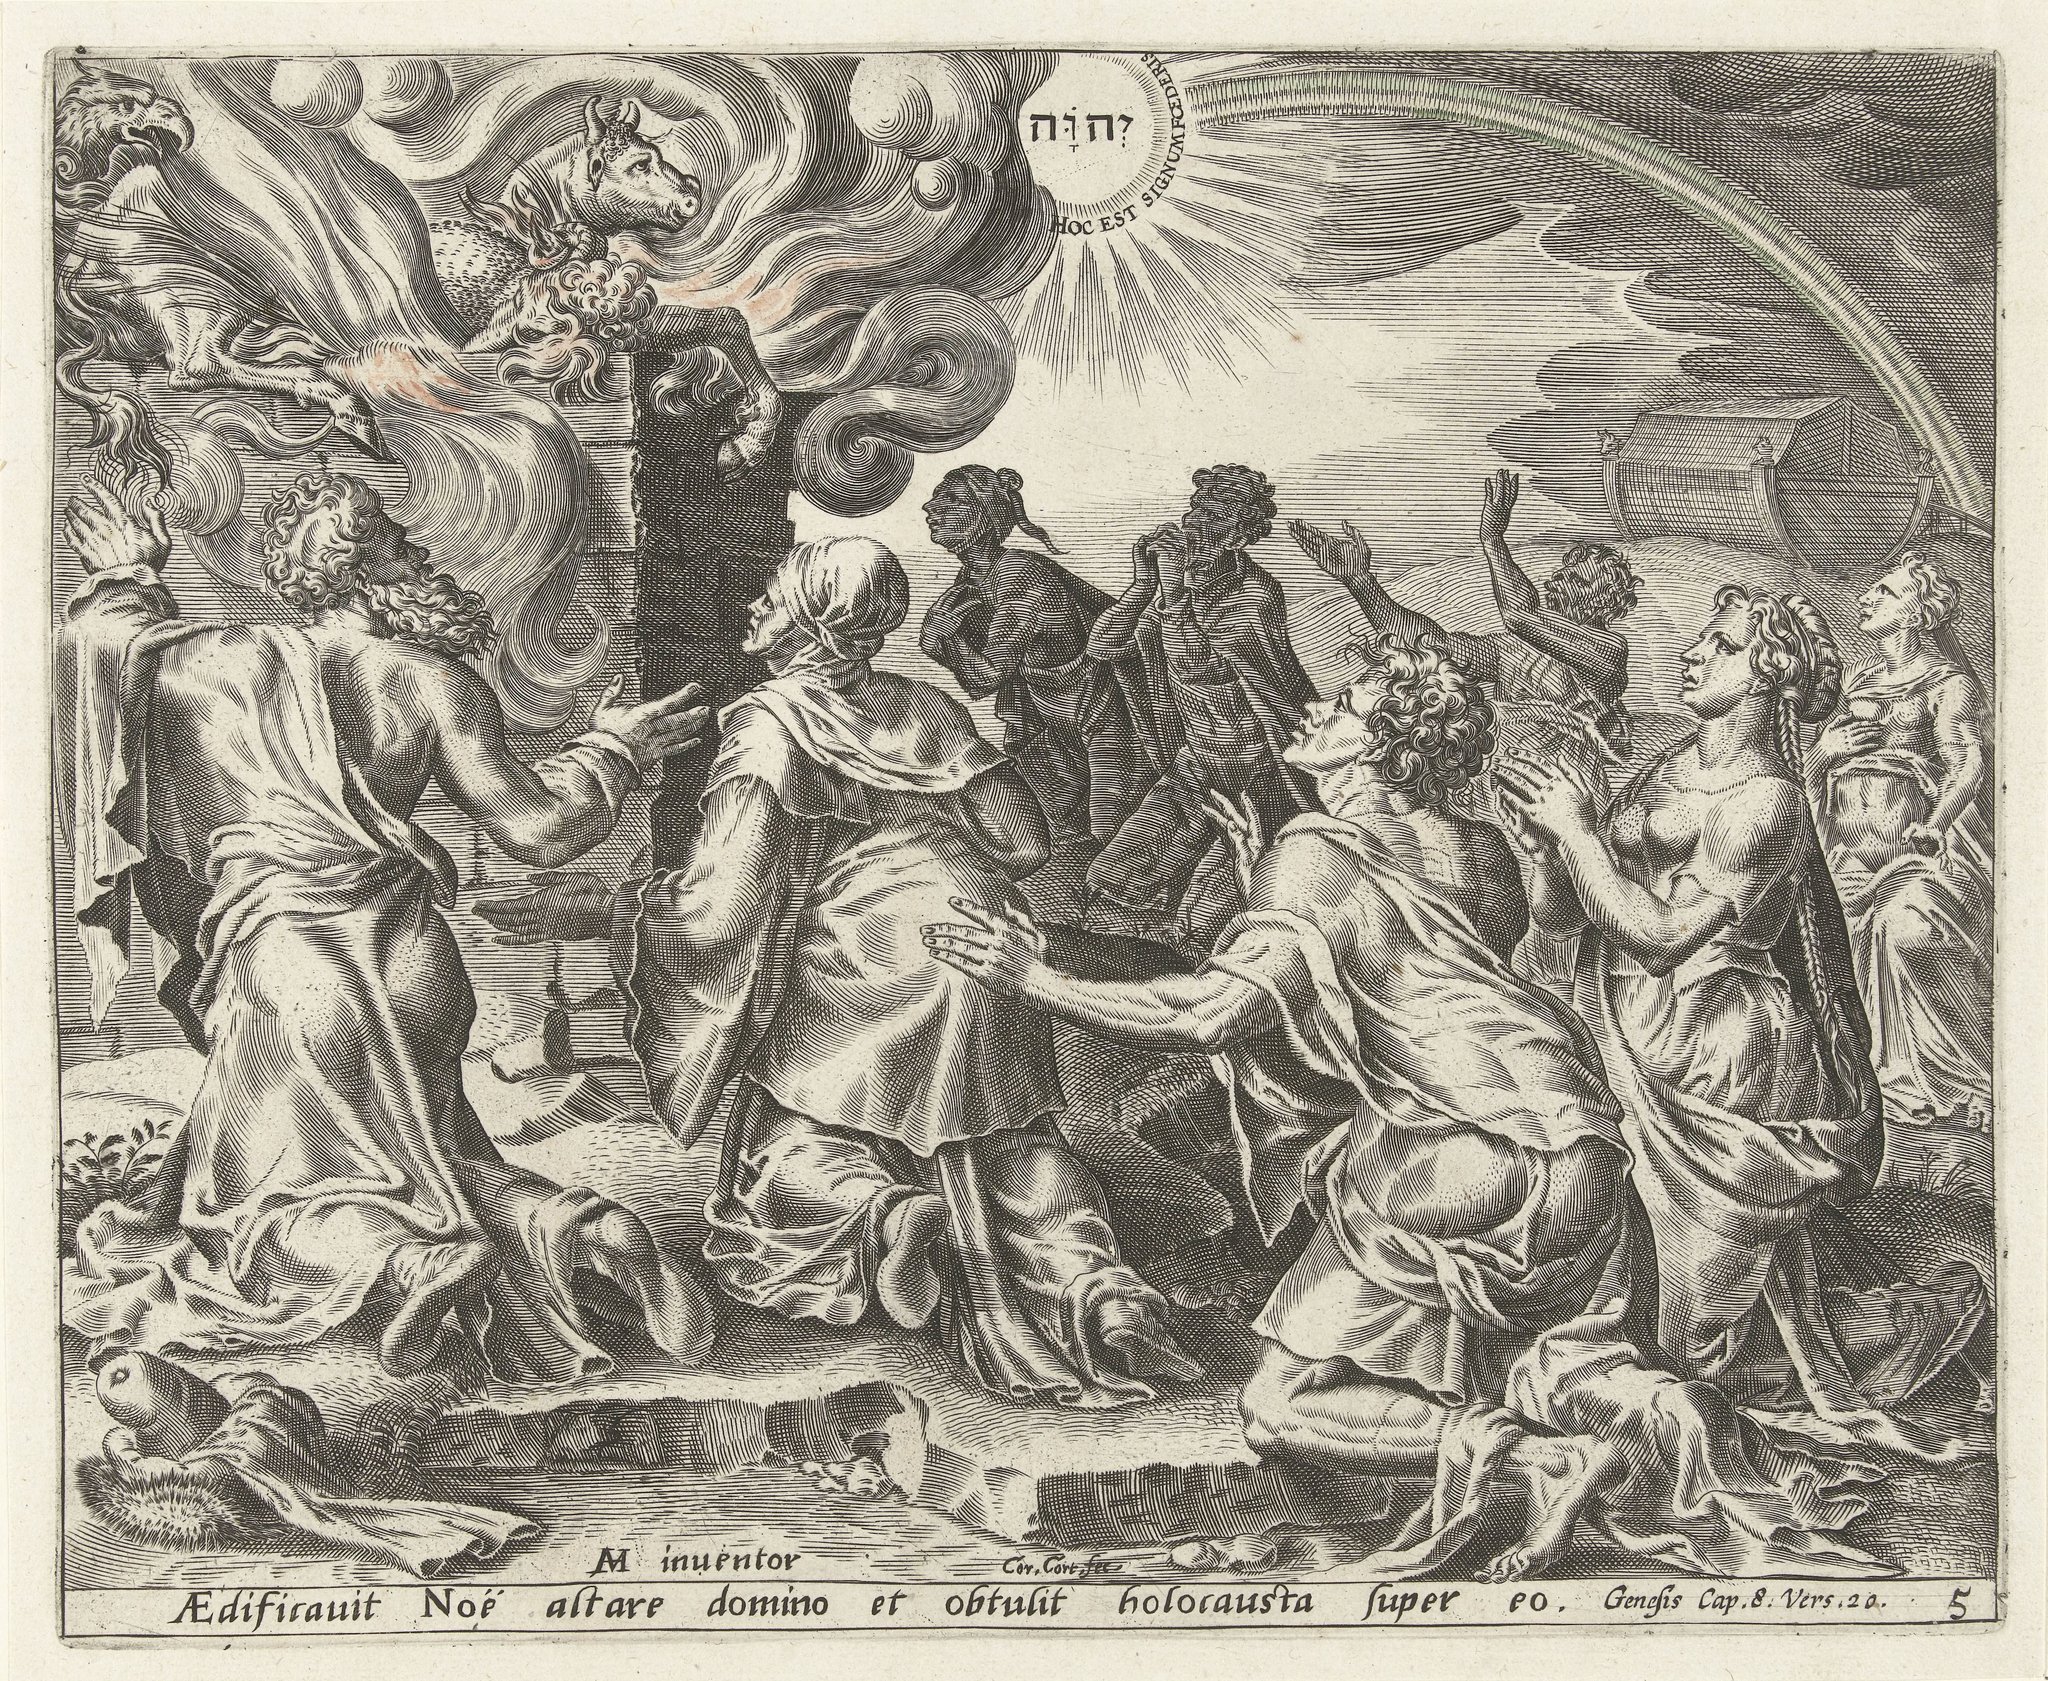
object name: print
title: Het offer van Noach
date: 1600-1652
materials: paper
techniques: brush, engraving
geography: amsterdam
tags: noah's sacrifice; various animals are offered, possibly a lamb, a dove and a ram (often combined with the rainbow of the covenant)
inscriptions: signature: ‘MH Inventor’, inscription: ‘HOC EST SIGNUM FOEDERIS’, caption: ‘Aedificavit Noë altare domino et obtulit holocausta super eo gen. cap. 8.’, number: ‘5’, collector's mark: Lugt 2228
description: Links een offeraltaar waarop verschillende dieren. Noach en zijn familie zitten geknield voor het altaar. In de lucht het symbool voor God (regenboog en zon met de hebreeuwse letters voor Jahweh). Rechtsachter staat op een heuvel de ark.